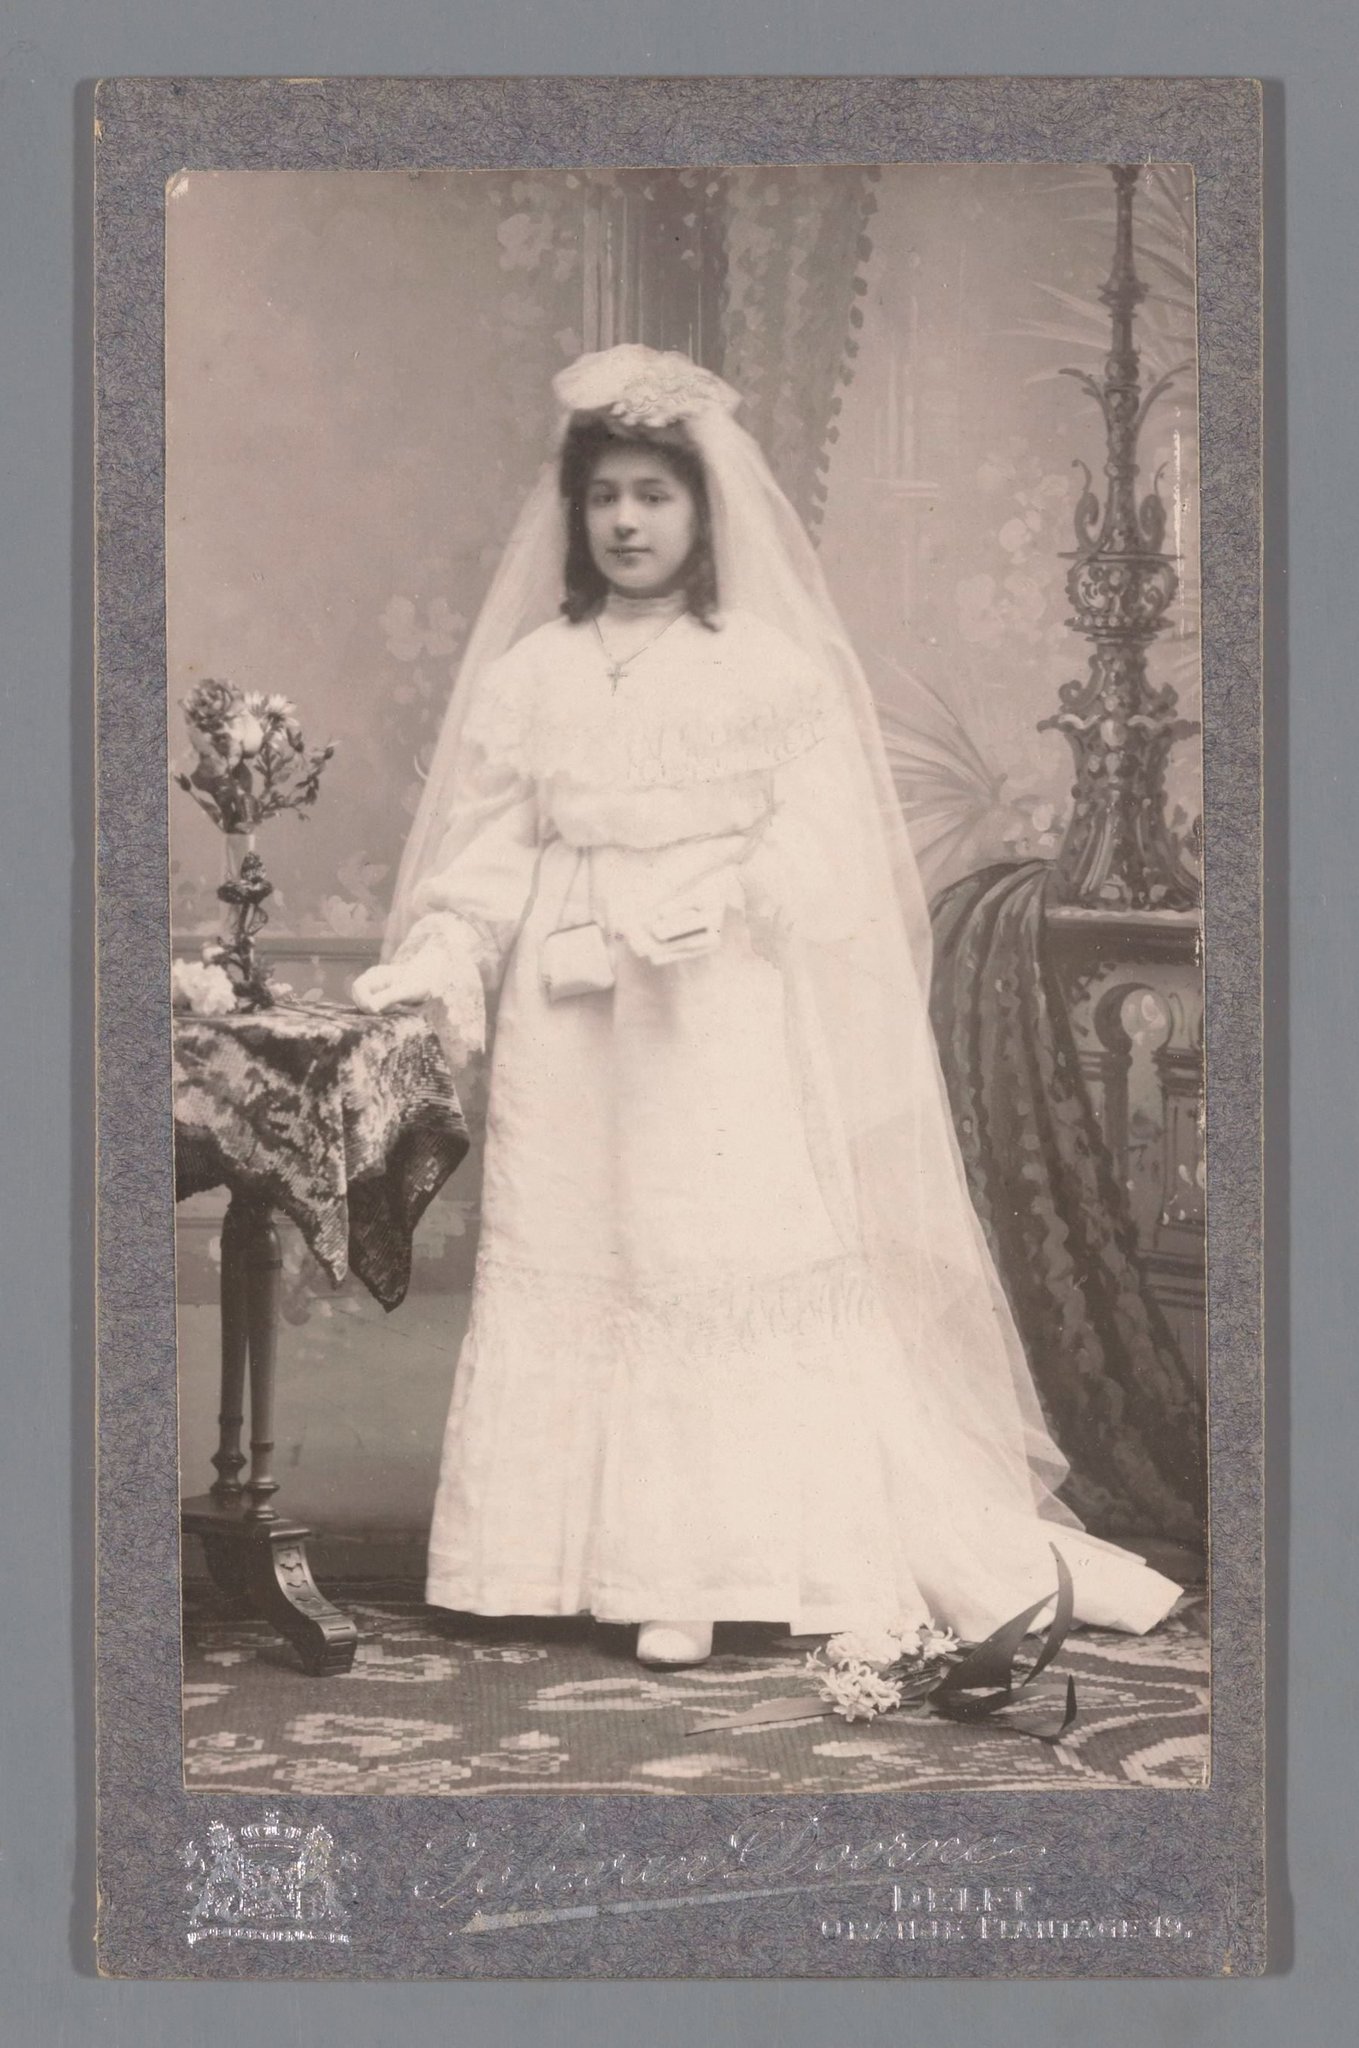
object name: carte de visite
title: Portret van een onbekend meisje in een communiejurk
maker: johannes van doorne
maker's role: fotograaf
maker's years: 1869-1926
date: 1899-1913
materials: cardboard, photographic support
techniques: daylight paper print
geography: delft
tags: first communion, communion dress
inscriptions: name: ‘Fotografie Joh. van Doorne Delft Oranje Plantage 19. Inrichting voor Vergrootingen. De plaat blijft voor nabestelling bewaard.’